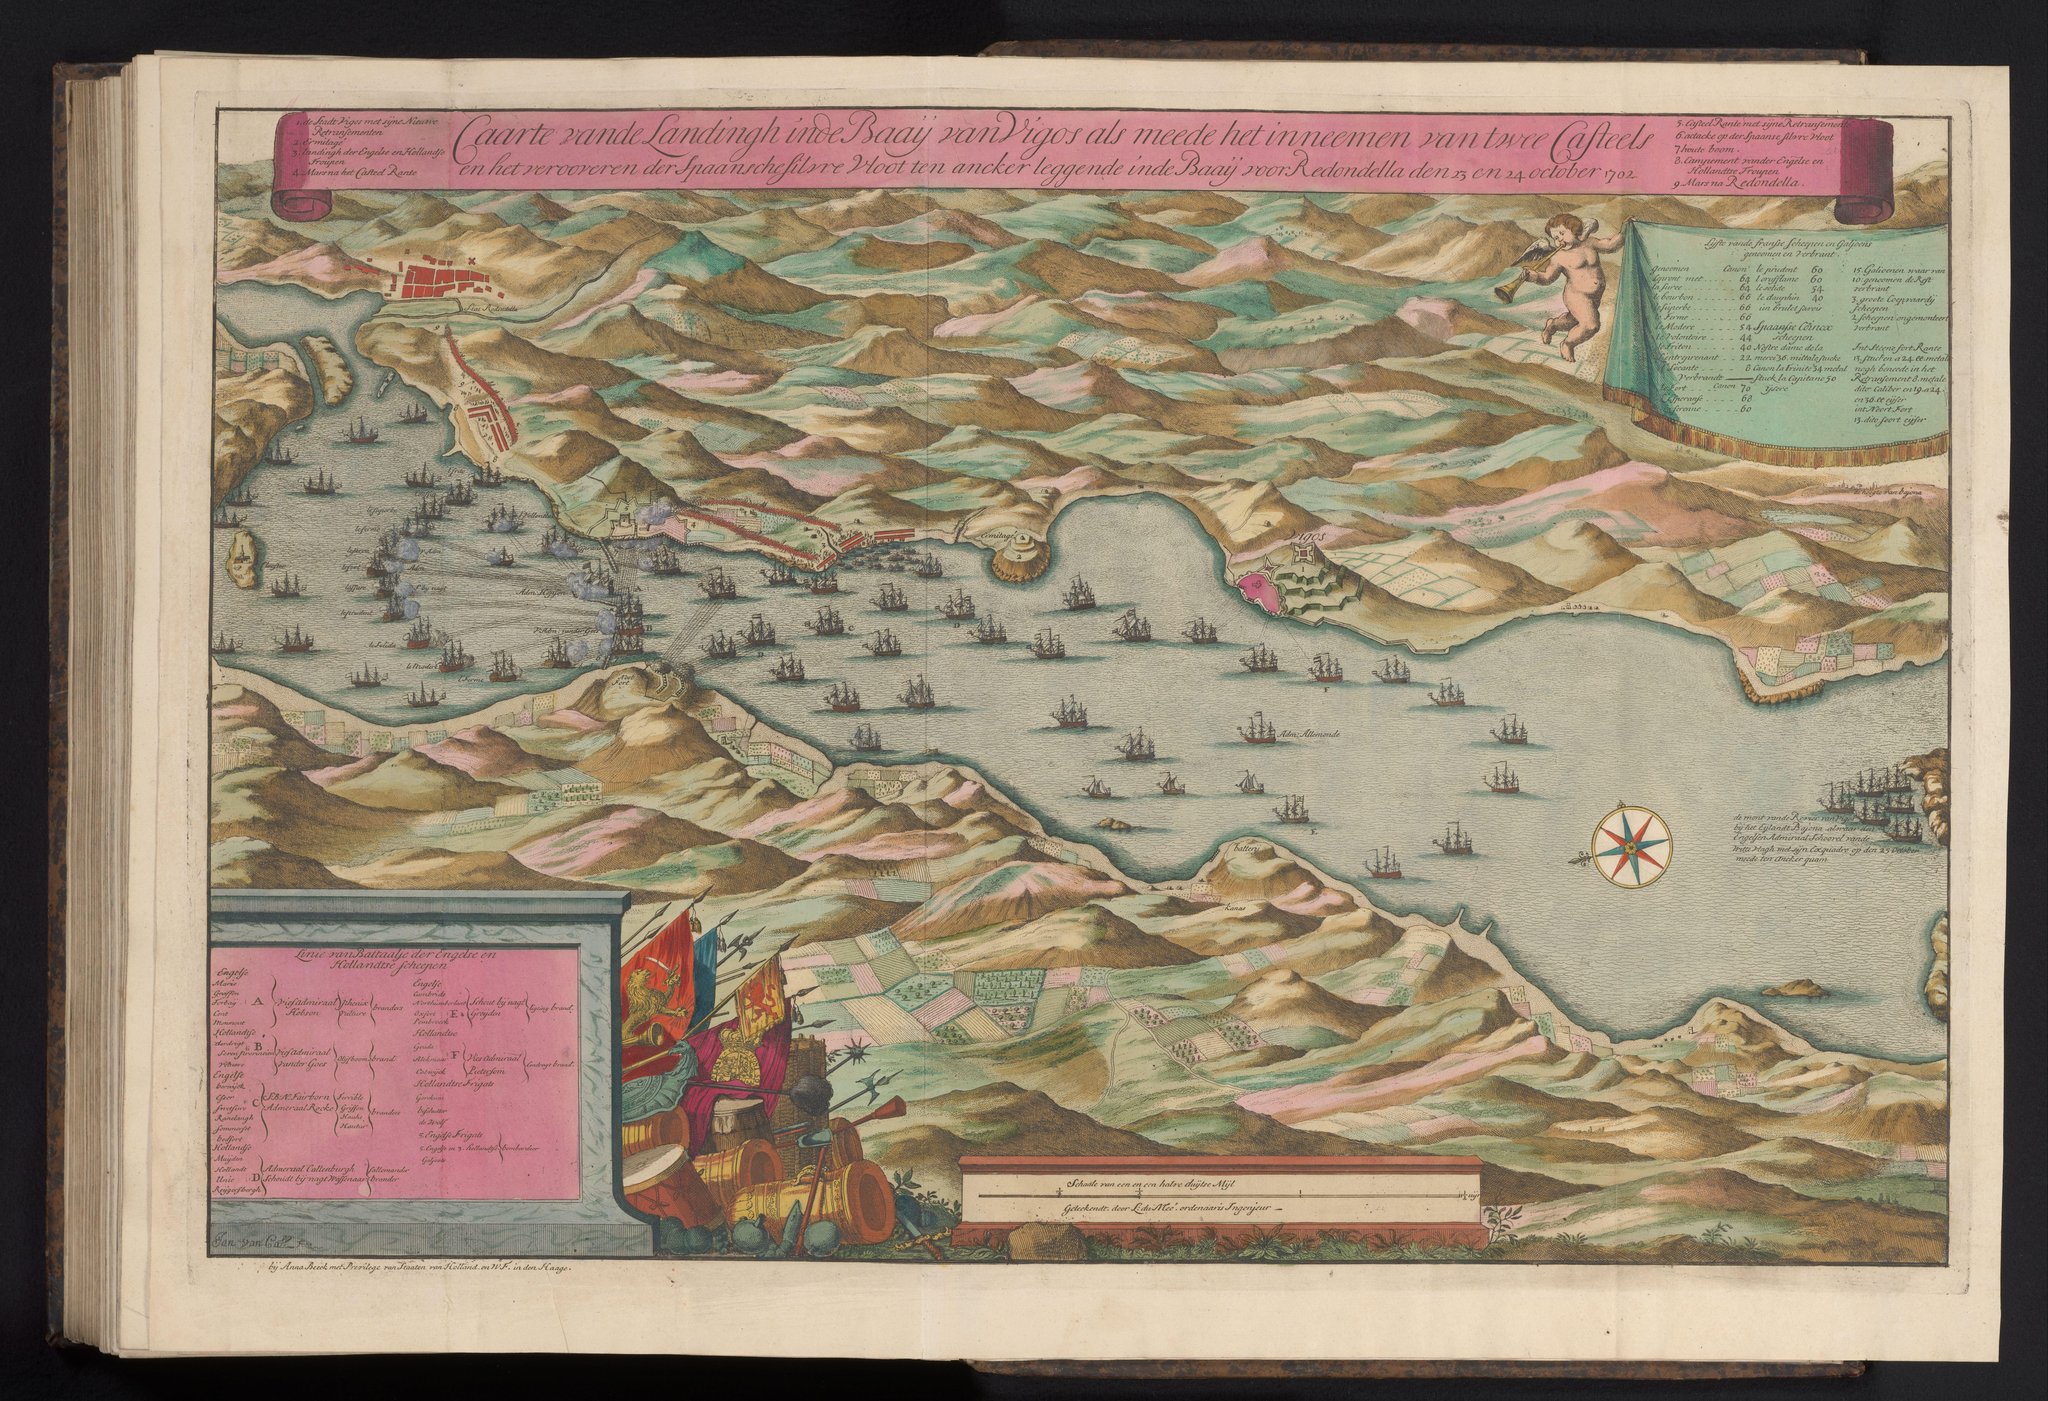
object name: print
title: Zeeslag in de baai bij Vigo en de verovering van de Spaanse zilvervloot, 1702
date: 1702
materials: paper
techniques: etching, hand coloring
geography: the hague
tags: maps of separate countries or regions, battle (+ naval force)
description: Kaart van de zeeslag in de baai van Vigo waarbij de Franse en Spaanse vloot op 23 oktober 1702 verslagen wordt door de gecombineerde Engels-Hollandse vloot. Rechtsboven een draperie met een lijst van de veroverde en verbrande Franse schepen; linksonder de slagorde van de Engelse en Hollandse schepen. Prent maakt deel uit van een album.